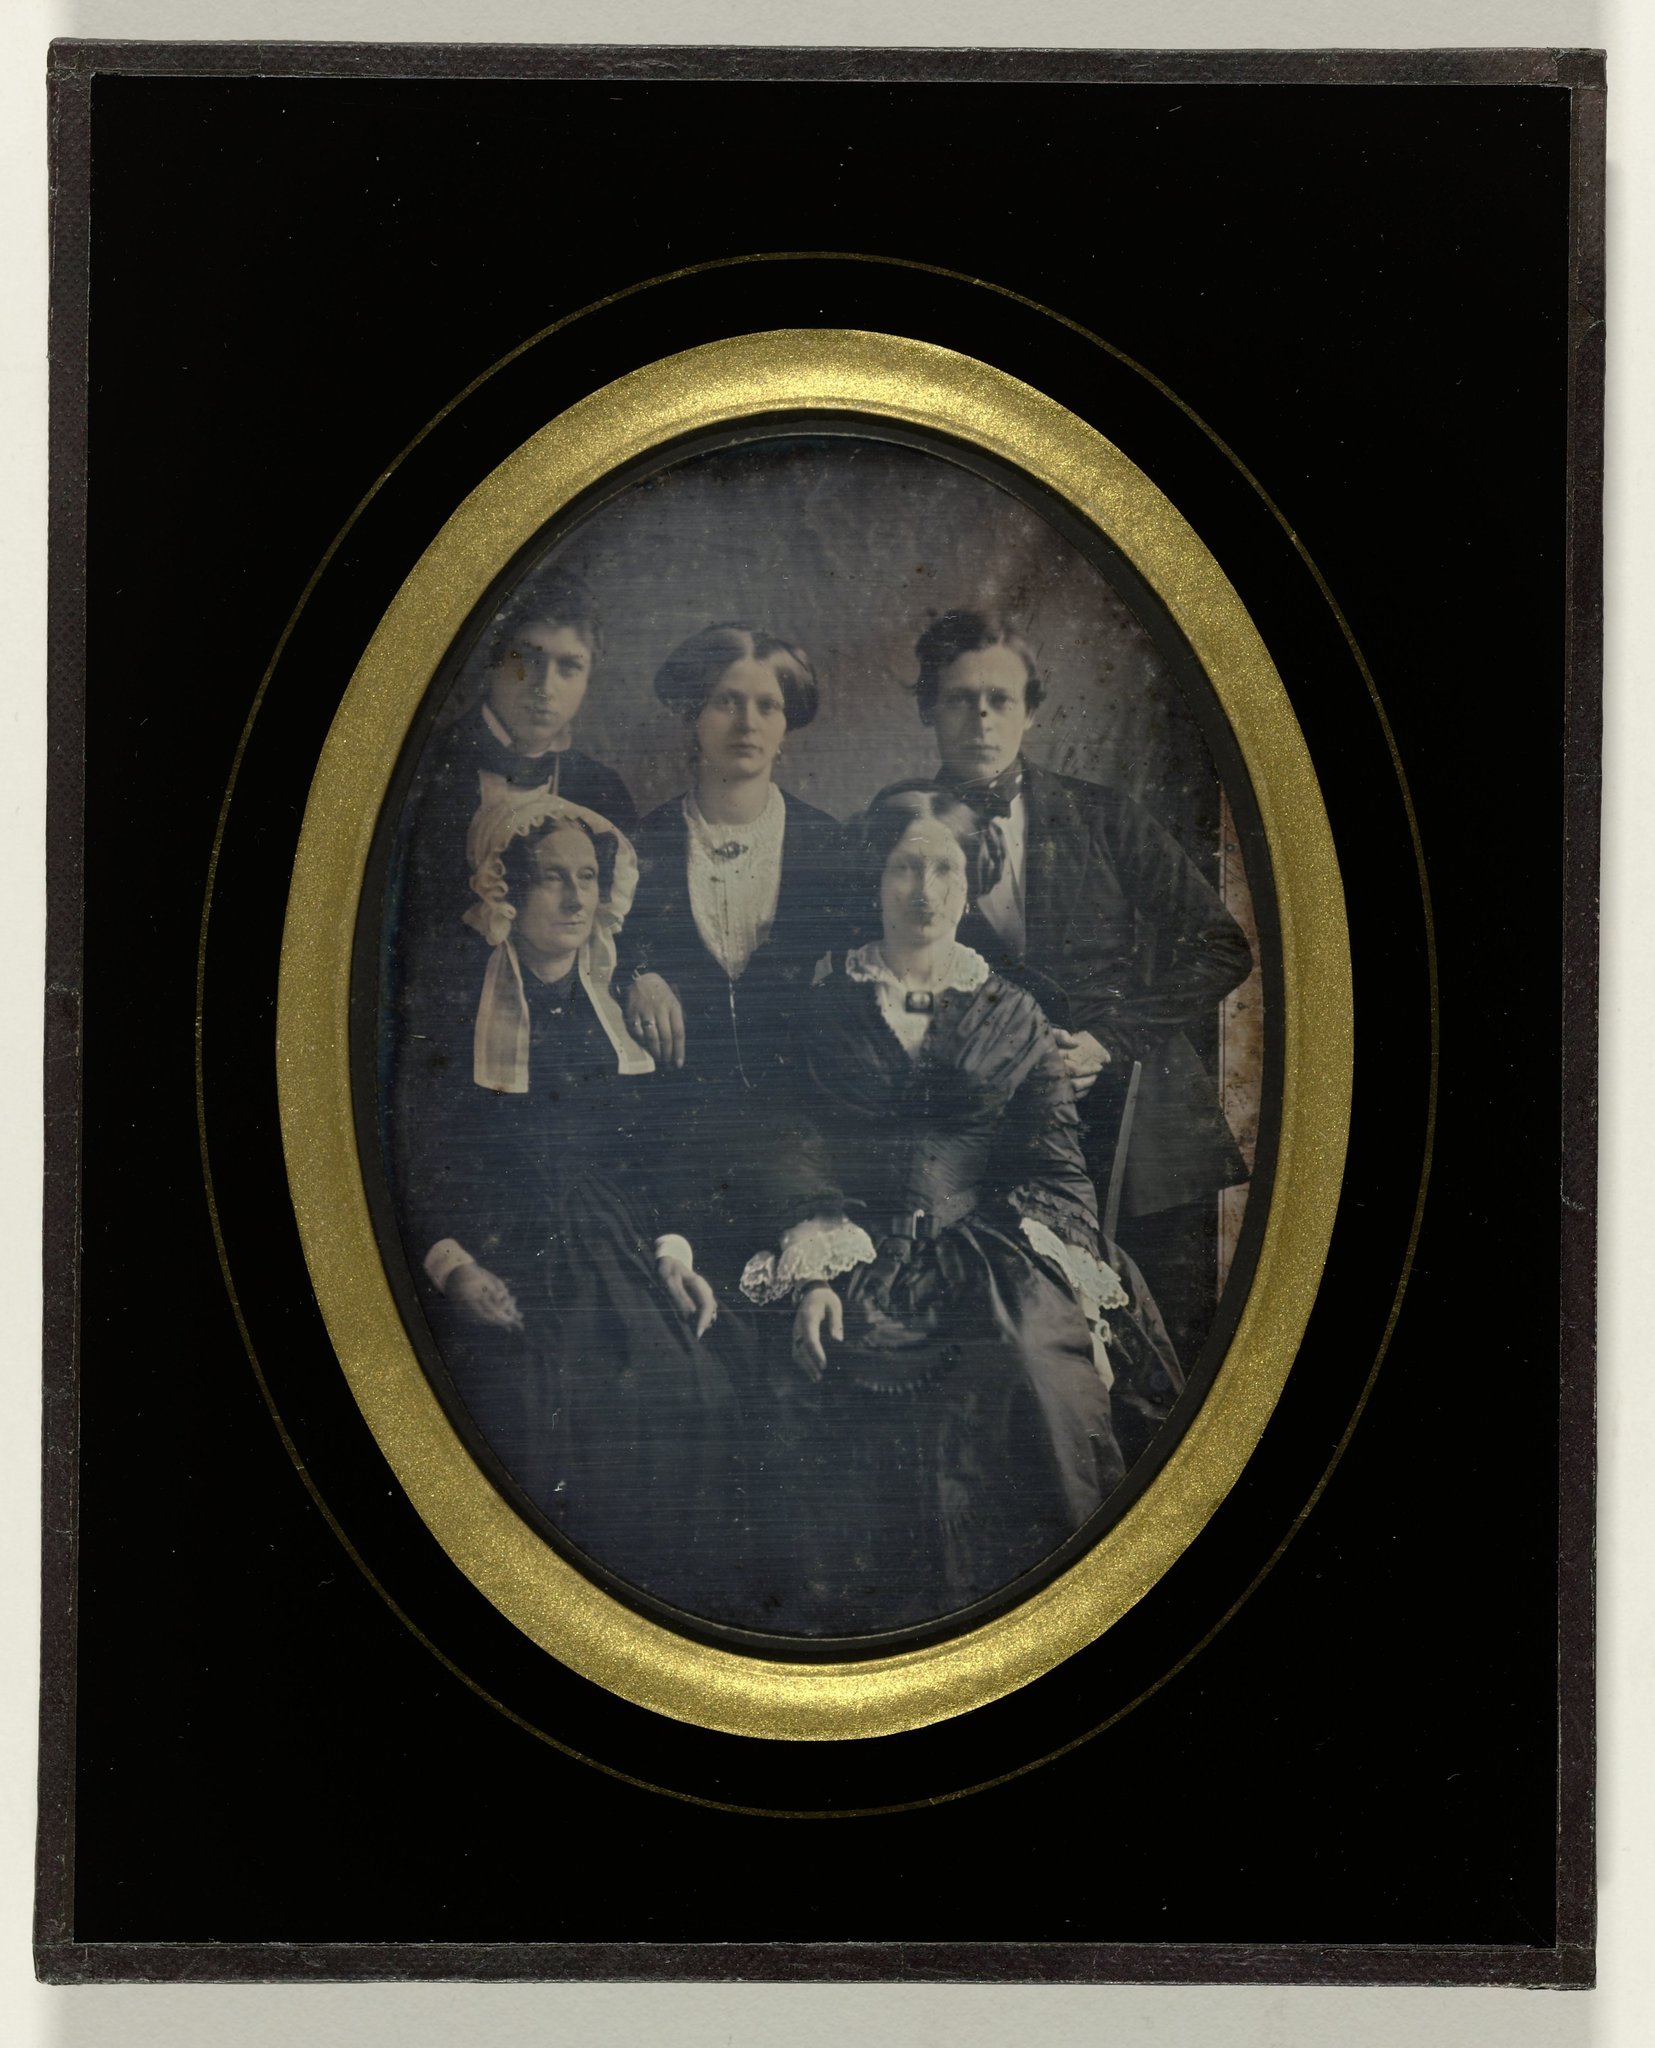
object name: photograph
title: Groepsportret van jkvr. Hester Adriana Catharina Broers-de Haze Bomme en vier van haar kinderen: Pieter Aarnout (links achter), Maria Helena Cornelia (midden achter), Willem Hubrecht Daniël (rechts achter) en Catharina Wilhelmina (rechts voor)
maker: Anonymous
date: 1850-1860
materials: copper, glass, paper, silver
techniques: daguerreotype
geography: netherlands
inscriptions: inscription: ‘Hester Adriana Catharina / de Haze Bomme / met haar kinderen / Catharina Wilhelmina Broers / later Bijleveld / Maria Helena Cornelia Broers / later Phaff / Willem Hubrecht Daniel Broers / Frans Jacob [doorgehaald voor:] Pieter Aarnout Broers / +- 1850’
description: Groepsportret in lijst van vijf personen: links voor zittend de moeder van de overige vier, die naast en achter haar zitten/staan.